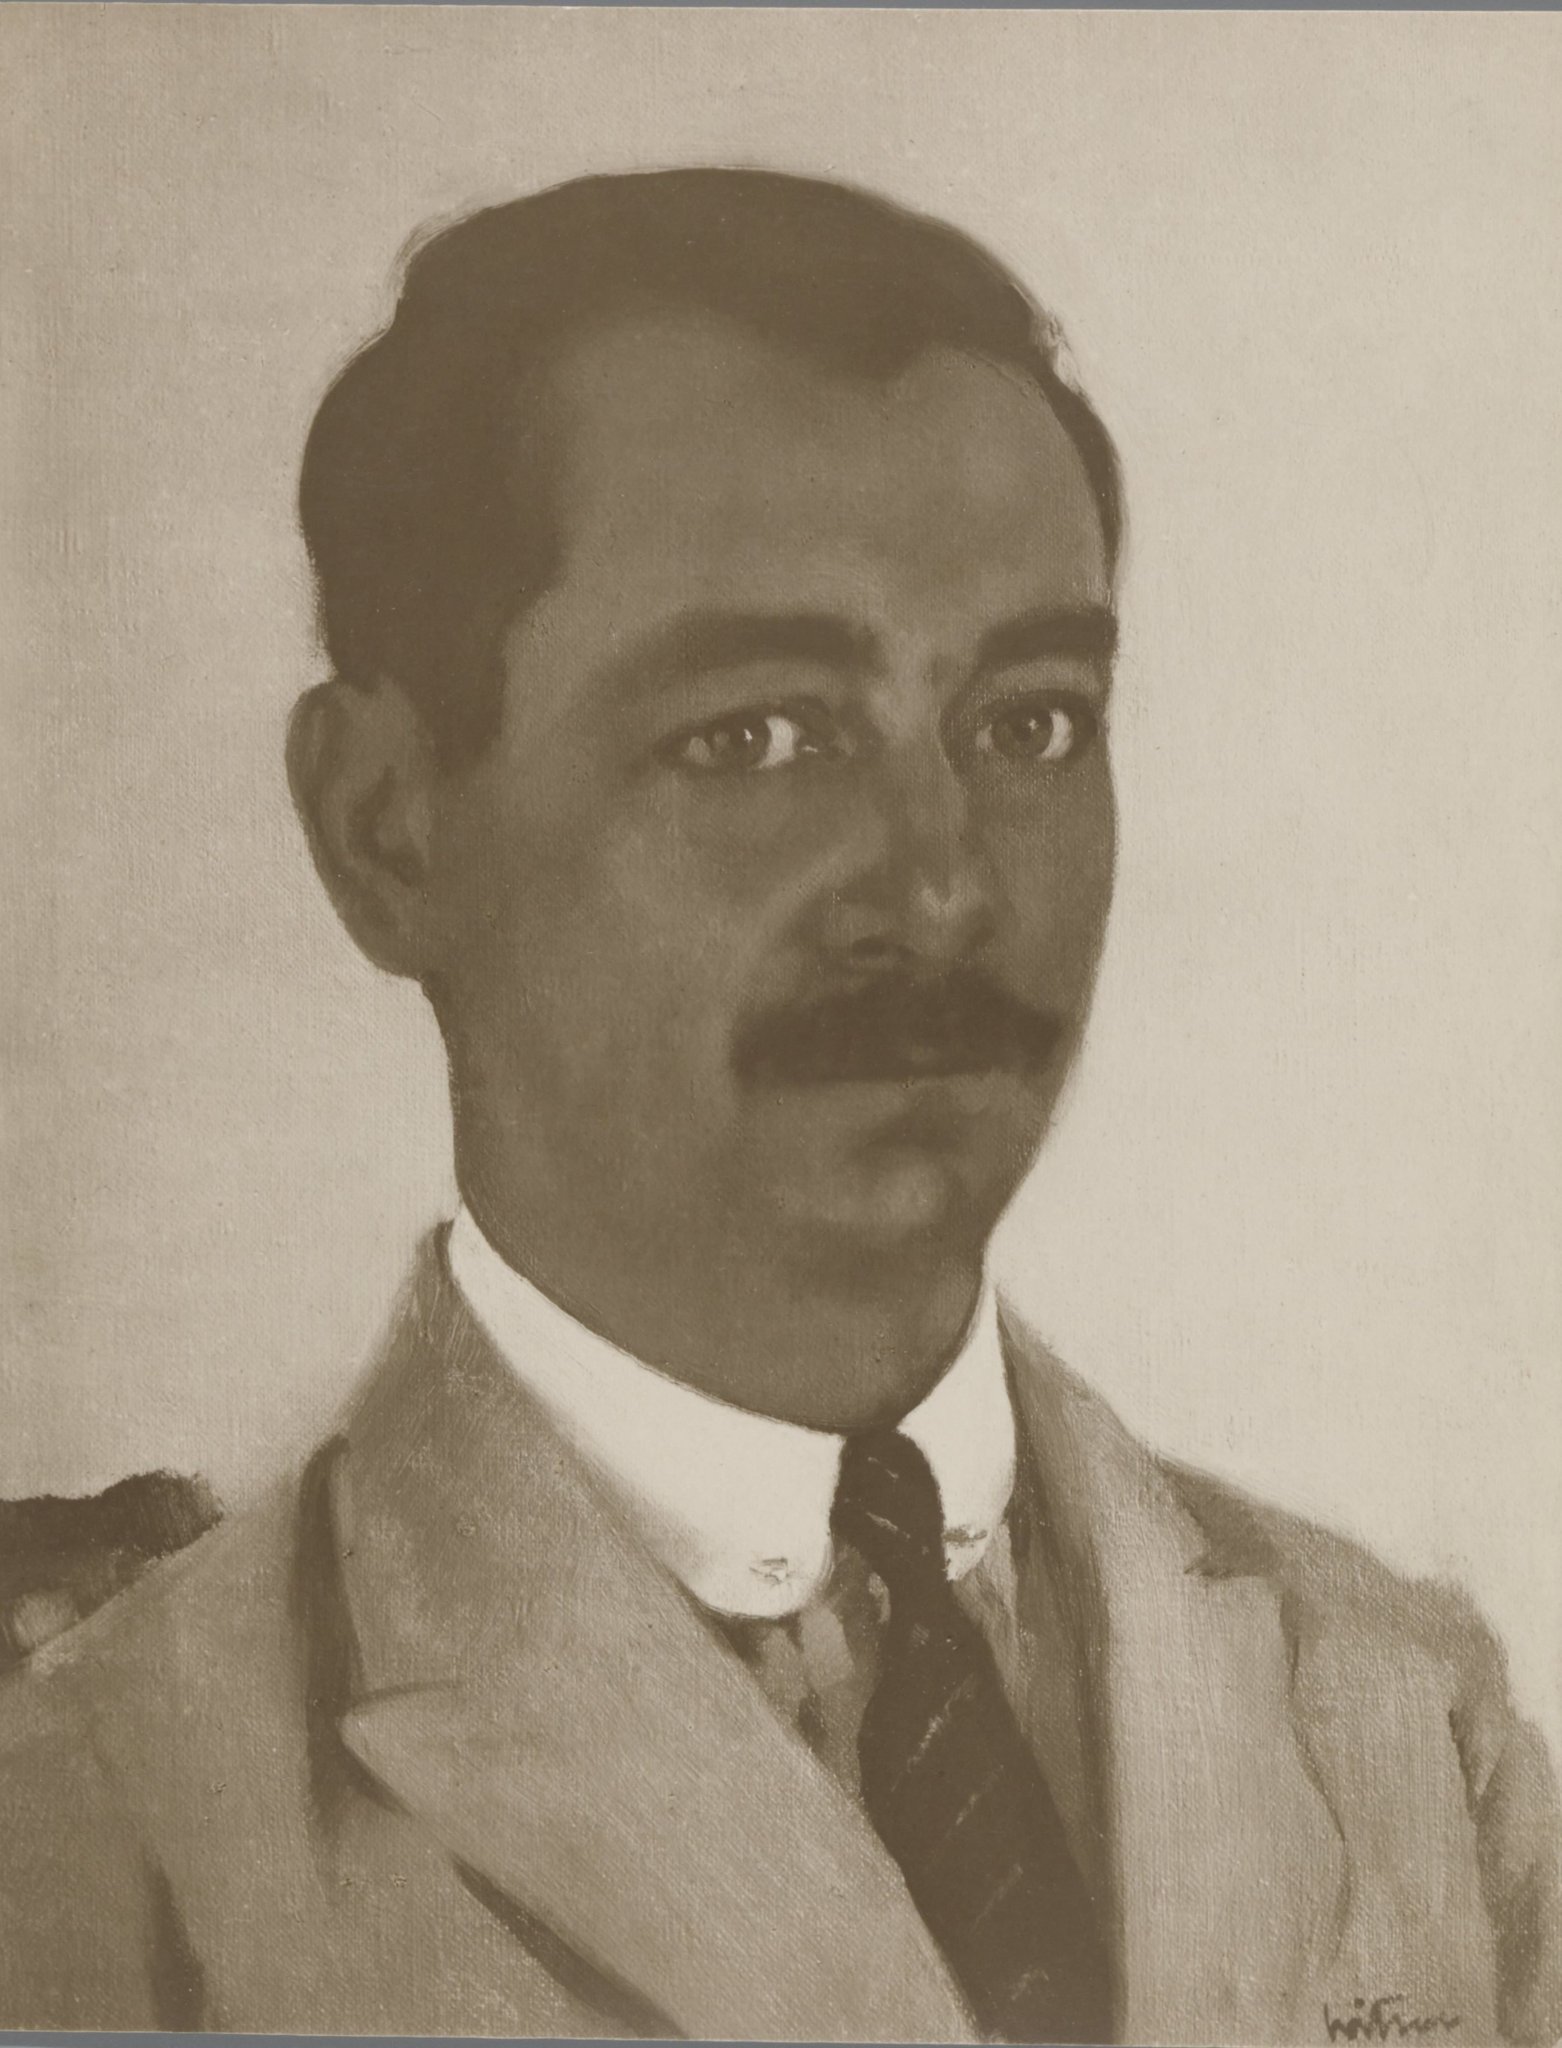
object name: photograph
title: Reproductie naar schilderij van Willem Witsen van een portret van een man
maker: Anonymous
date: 1860-1915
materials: paper, photographic support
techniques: gelatin silver print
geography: netherlands